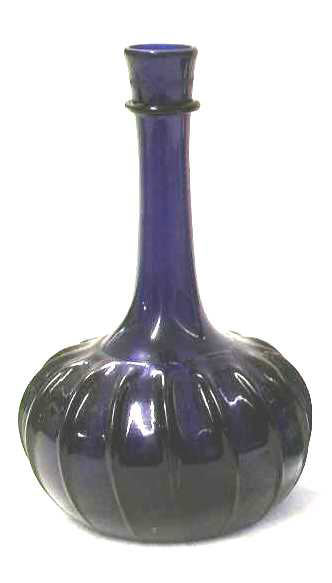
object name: bottle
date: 1601-1700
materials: glass